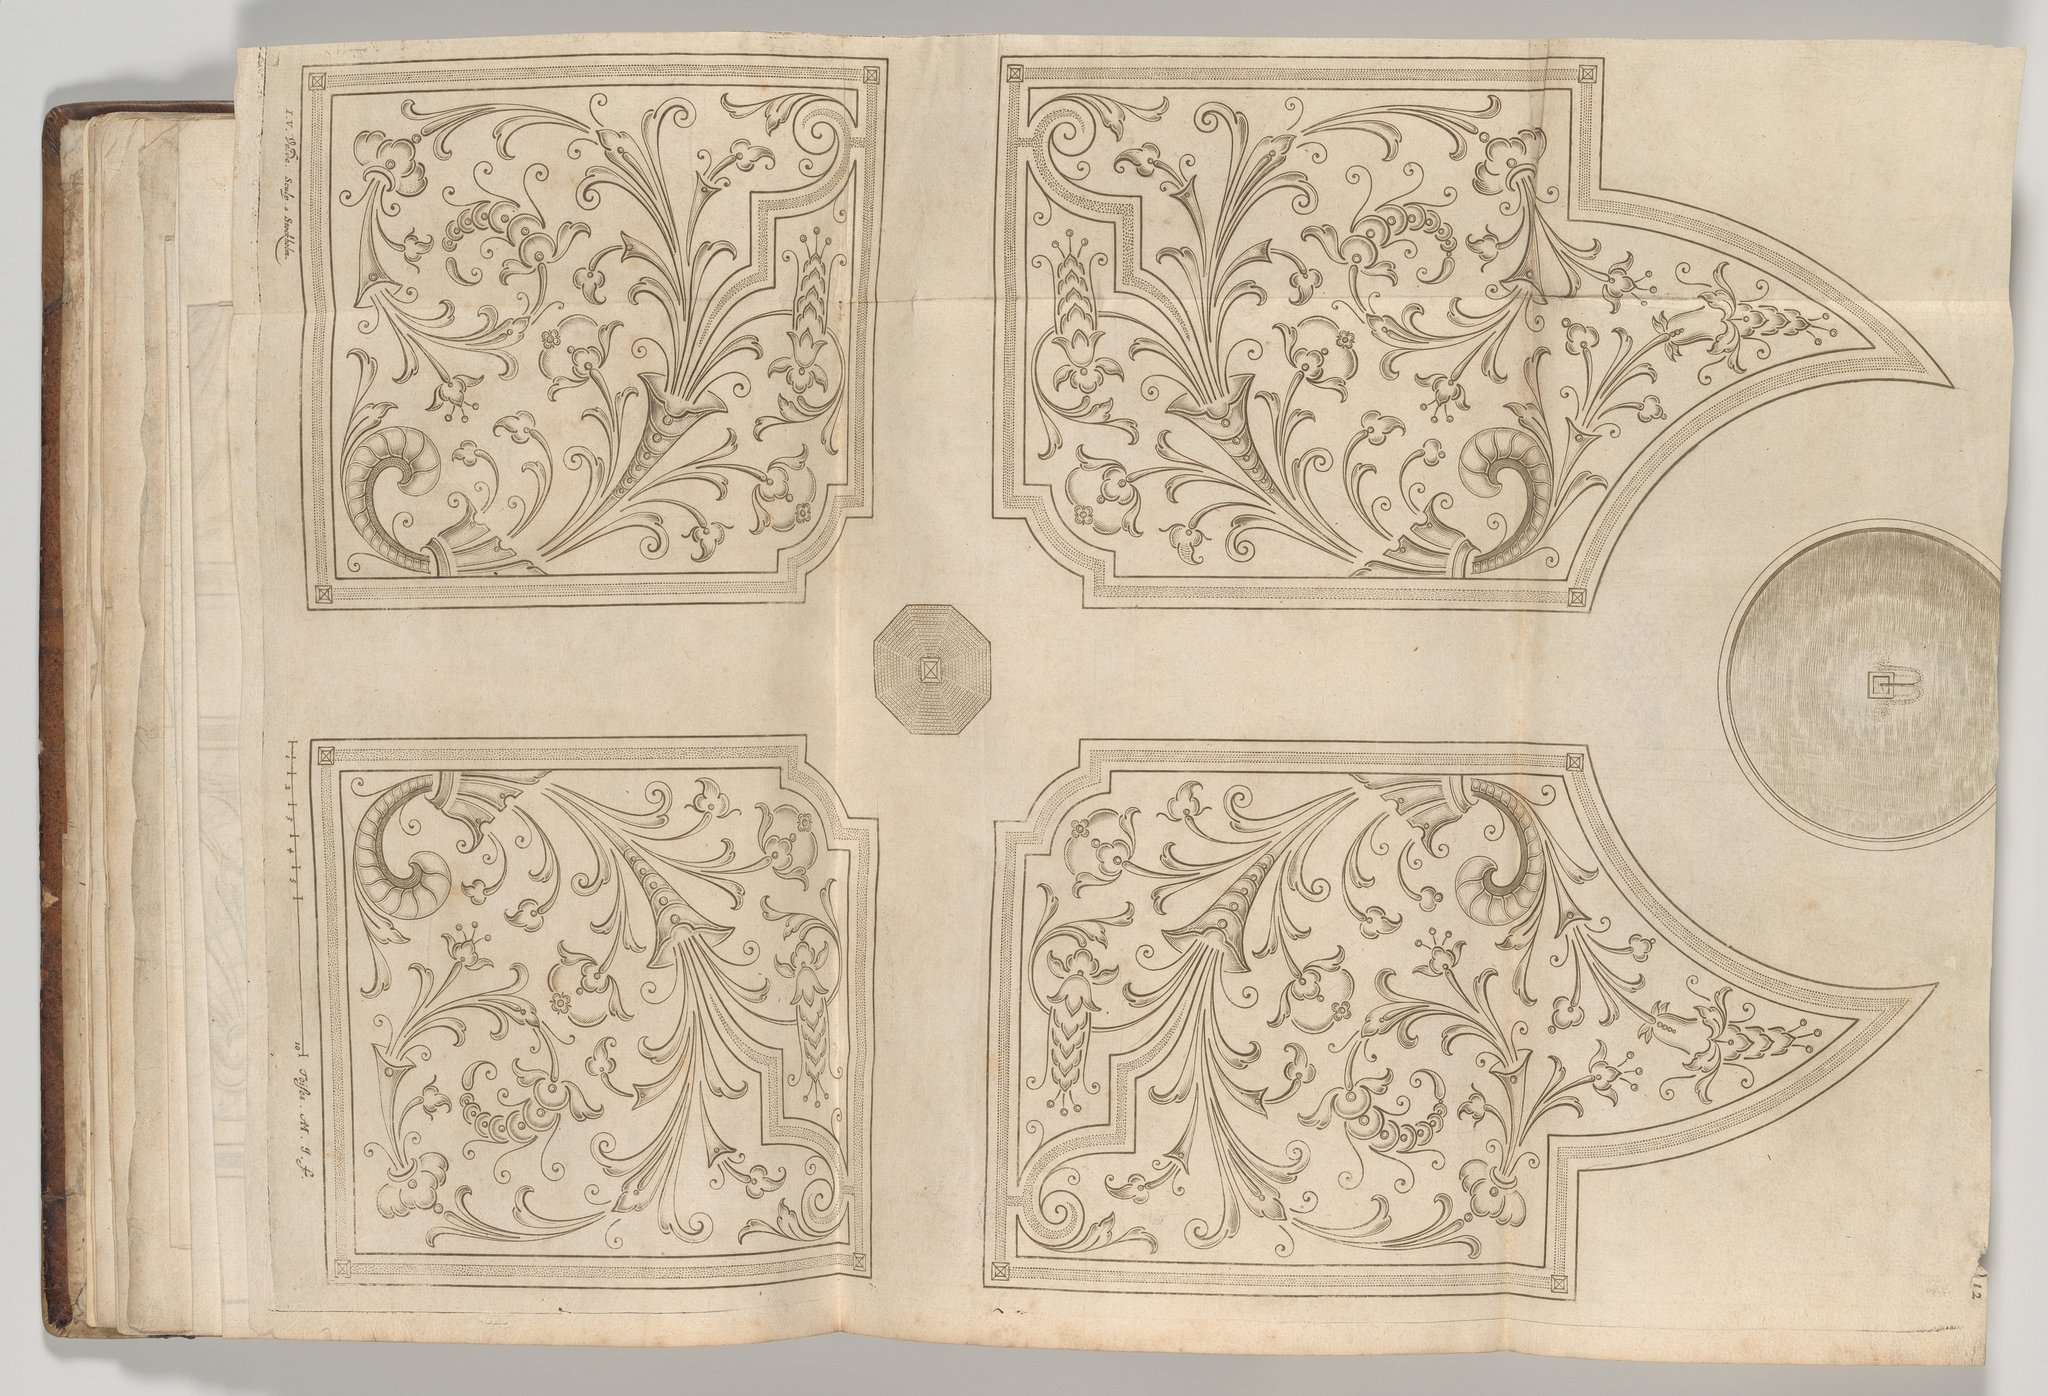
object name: book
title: Design for a fountain and four square parterres for a pleasure garden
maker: andré mollet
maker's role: designer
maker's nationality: french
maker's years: 17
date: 1651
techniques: engraving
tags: gardens